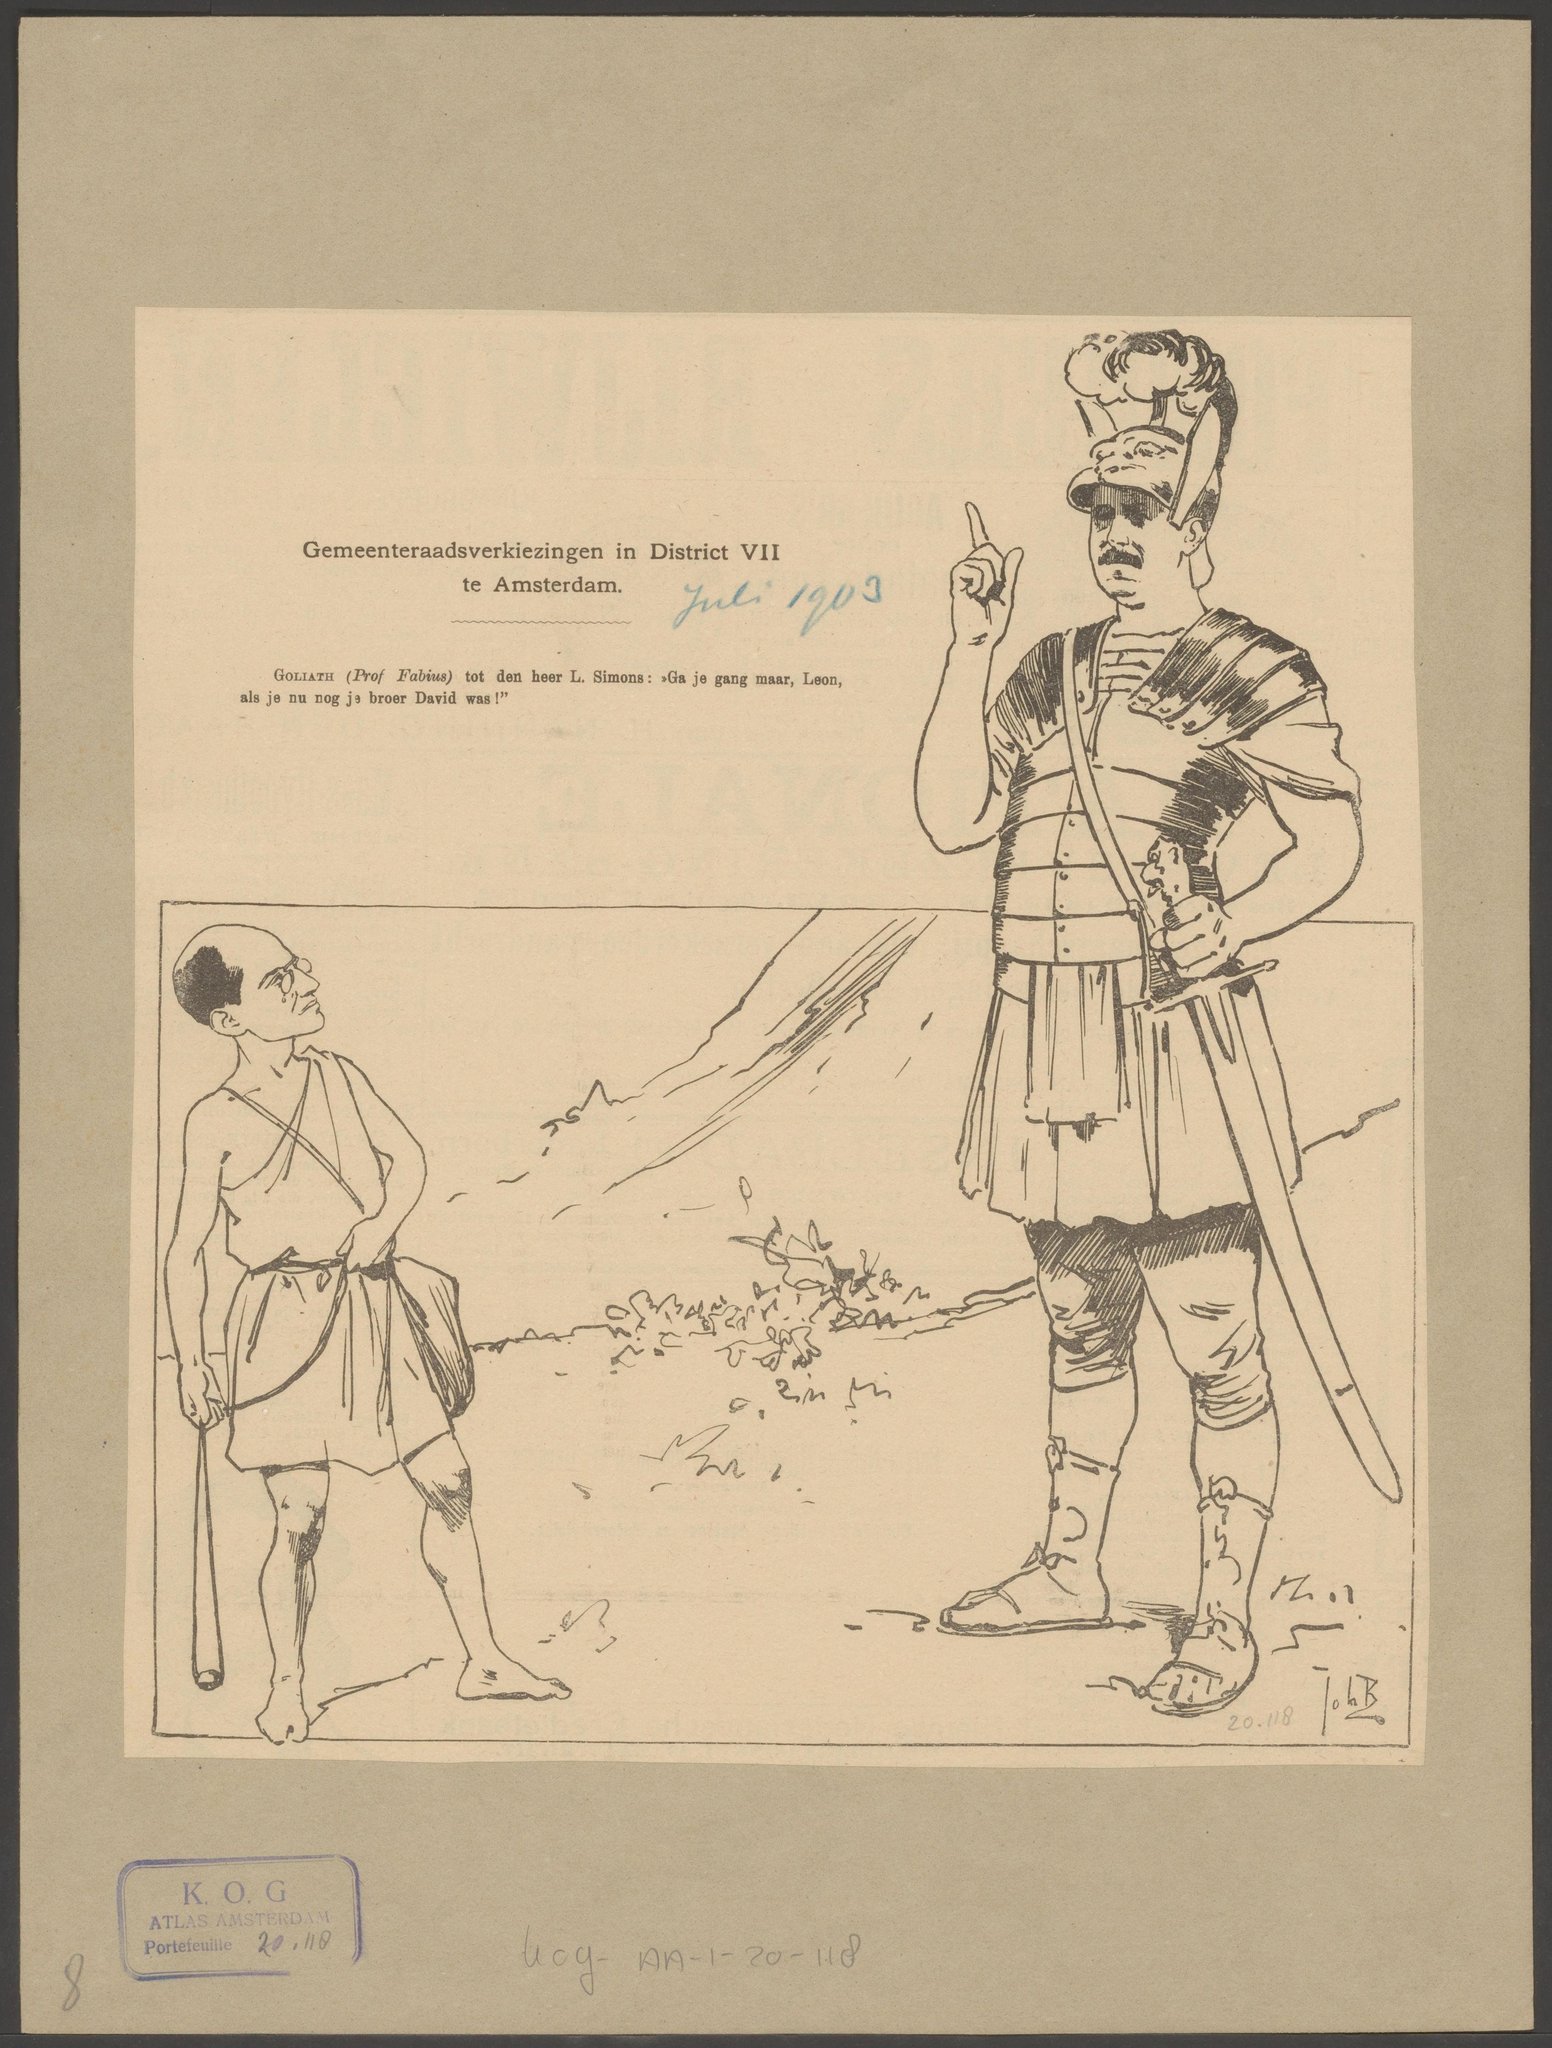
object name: photomechanical print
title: Gemeenteraadsverkiezingen in District VII te Amsterdam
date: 1903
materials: paper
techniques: letterpress printing, line block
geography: amsterdam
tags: the hague, david speaks with goliath, politician, e.g. party leader, political caricatures and satires, amsterdam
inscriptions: collector's mark: Lugt 1641b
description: Onderwerpsrubriek binnen de Atlas Amsterdam: Verkiezingen Gemeenteraad.